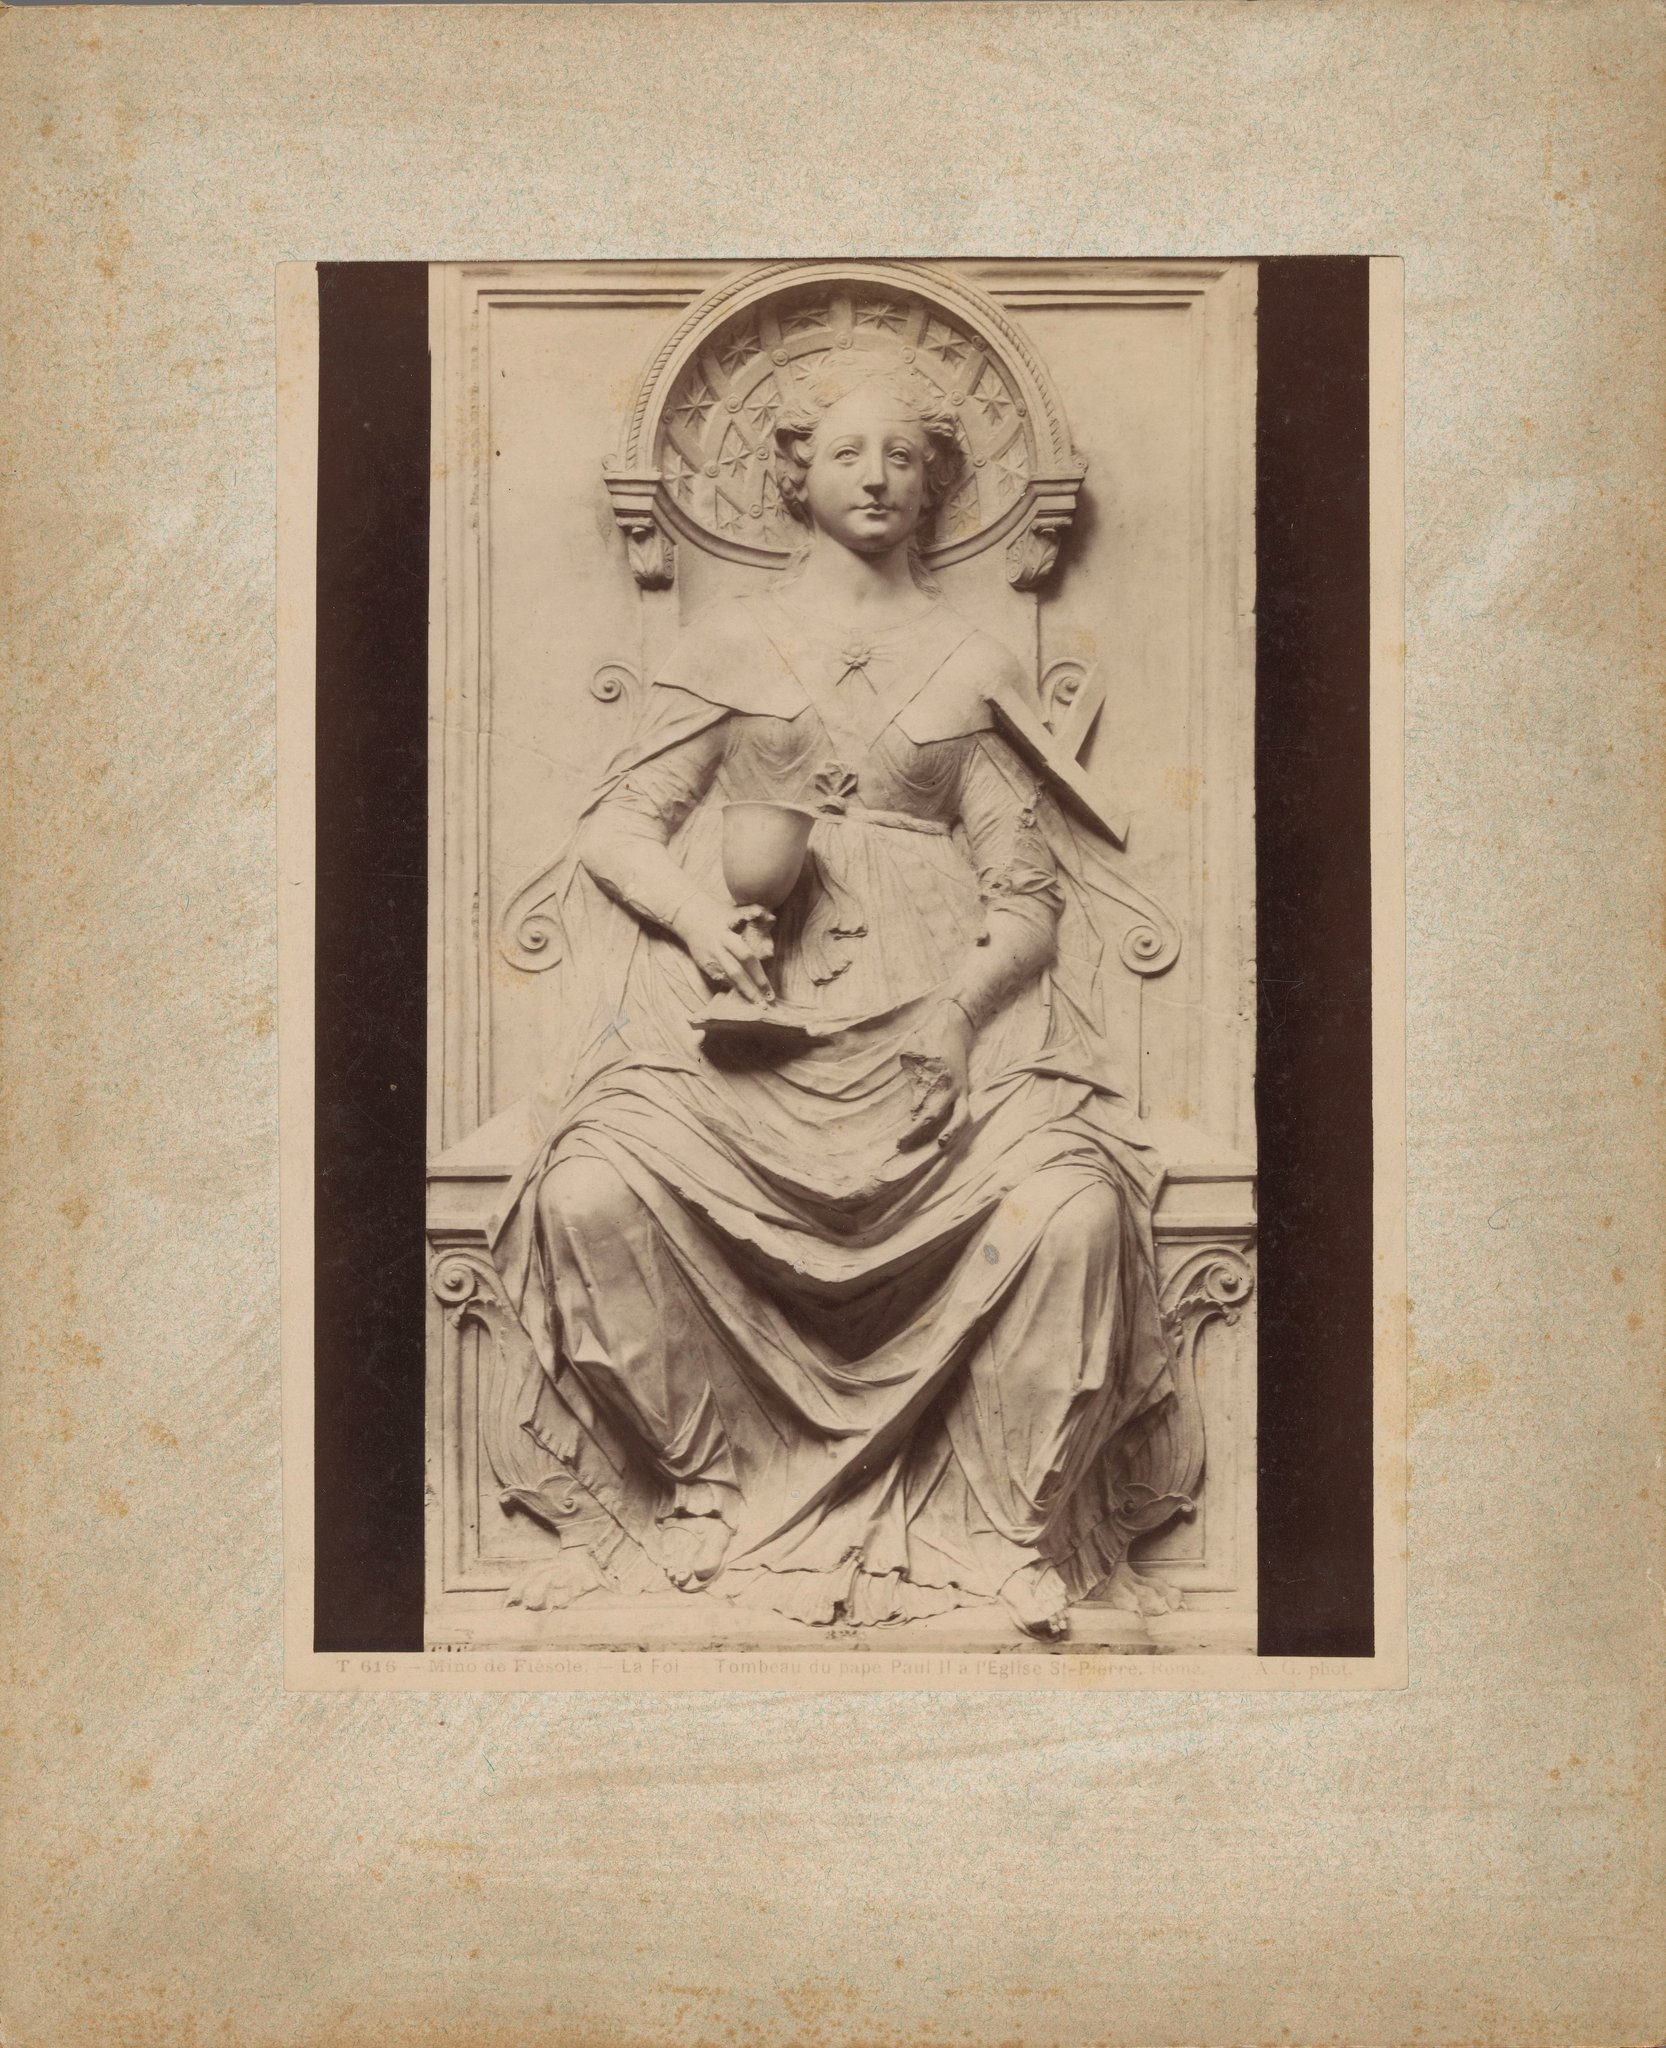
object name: photograph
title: Mino de Fiesole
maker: adolphe giraudon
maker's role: publisher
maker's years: 1849-1929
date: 1850-1900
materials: cardboard, photographic support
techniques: albumen print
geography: vatican city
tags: adult woman, chalice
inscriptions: collector's mark: ‘Rijks normaalschool voor teekenonderwijzers Amsterdam’, number: ‘T616’, inscription: ‘Tombeau du pape Paul II a l'Eglise St.-Pierre. Rome. A.G. phot.’